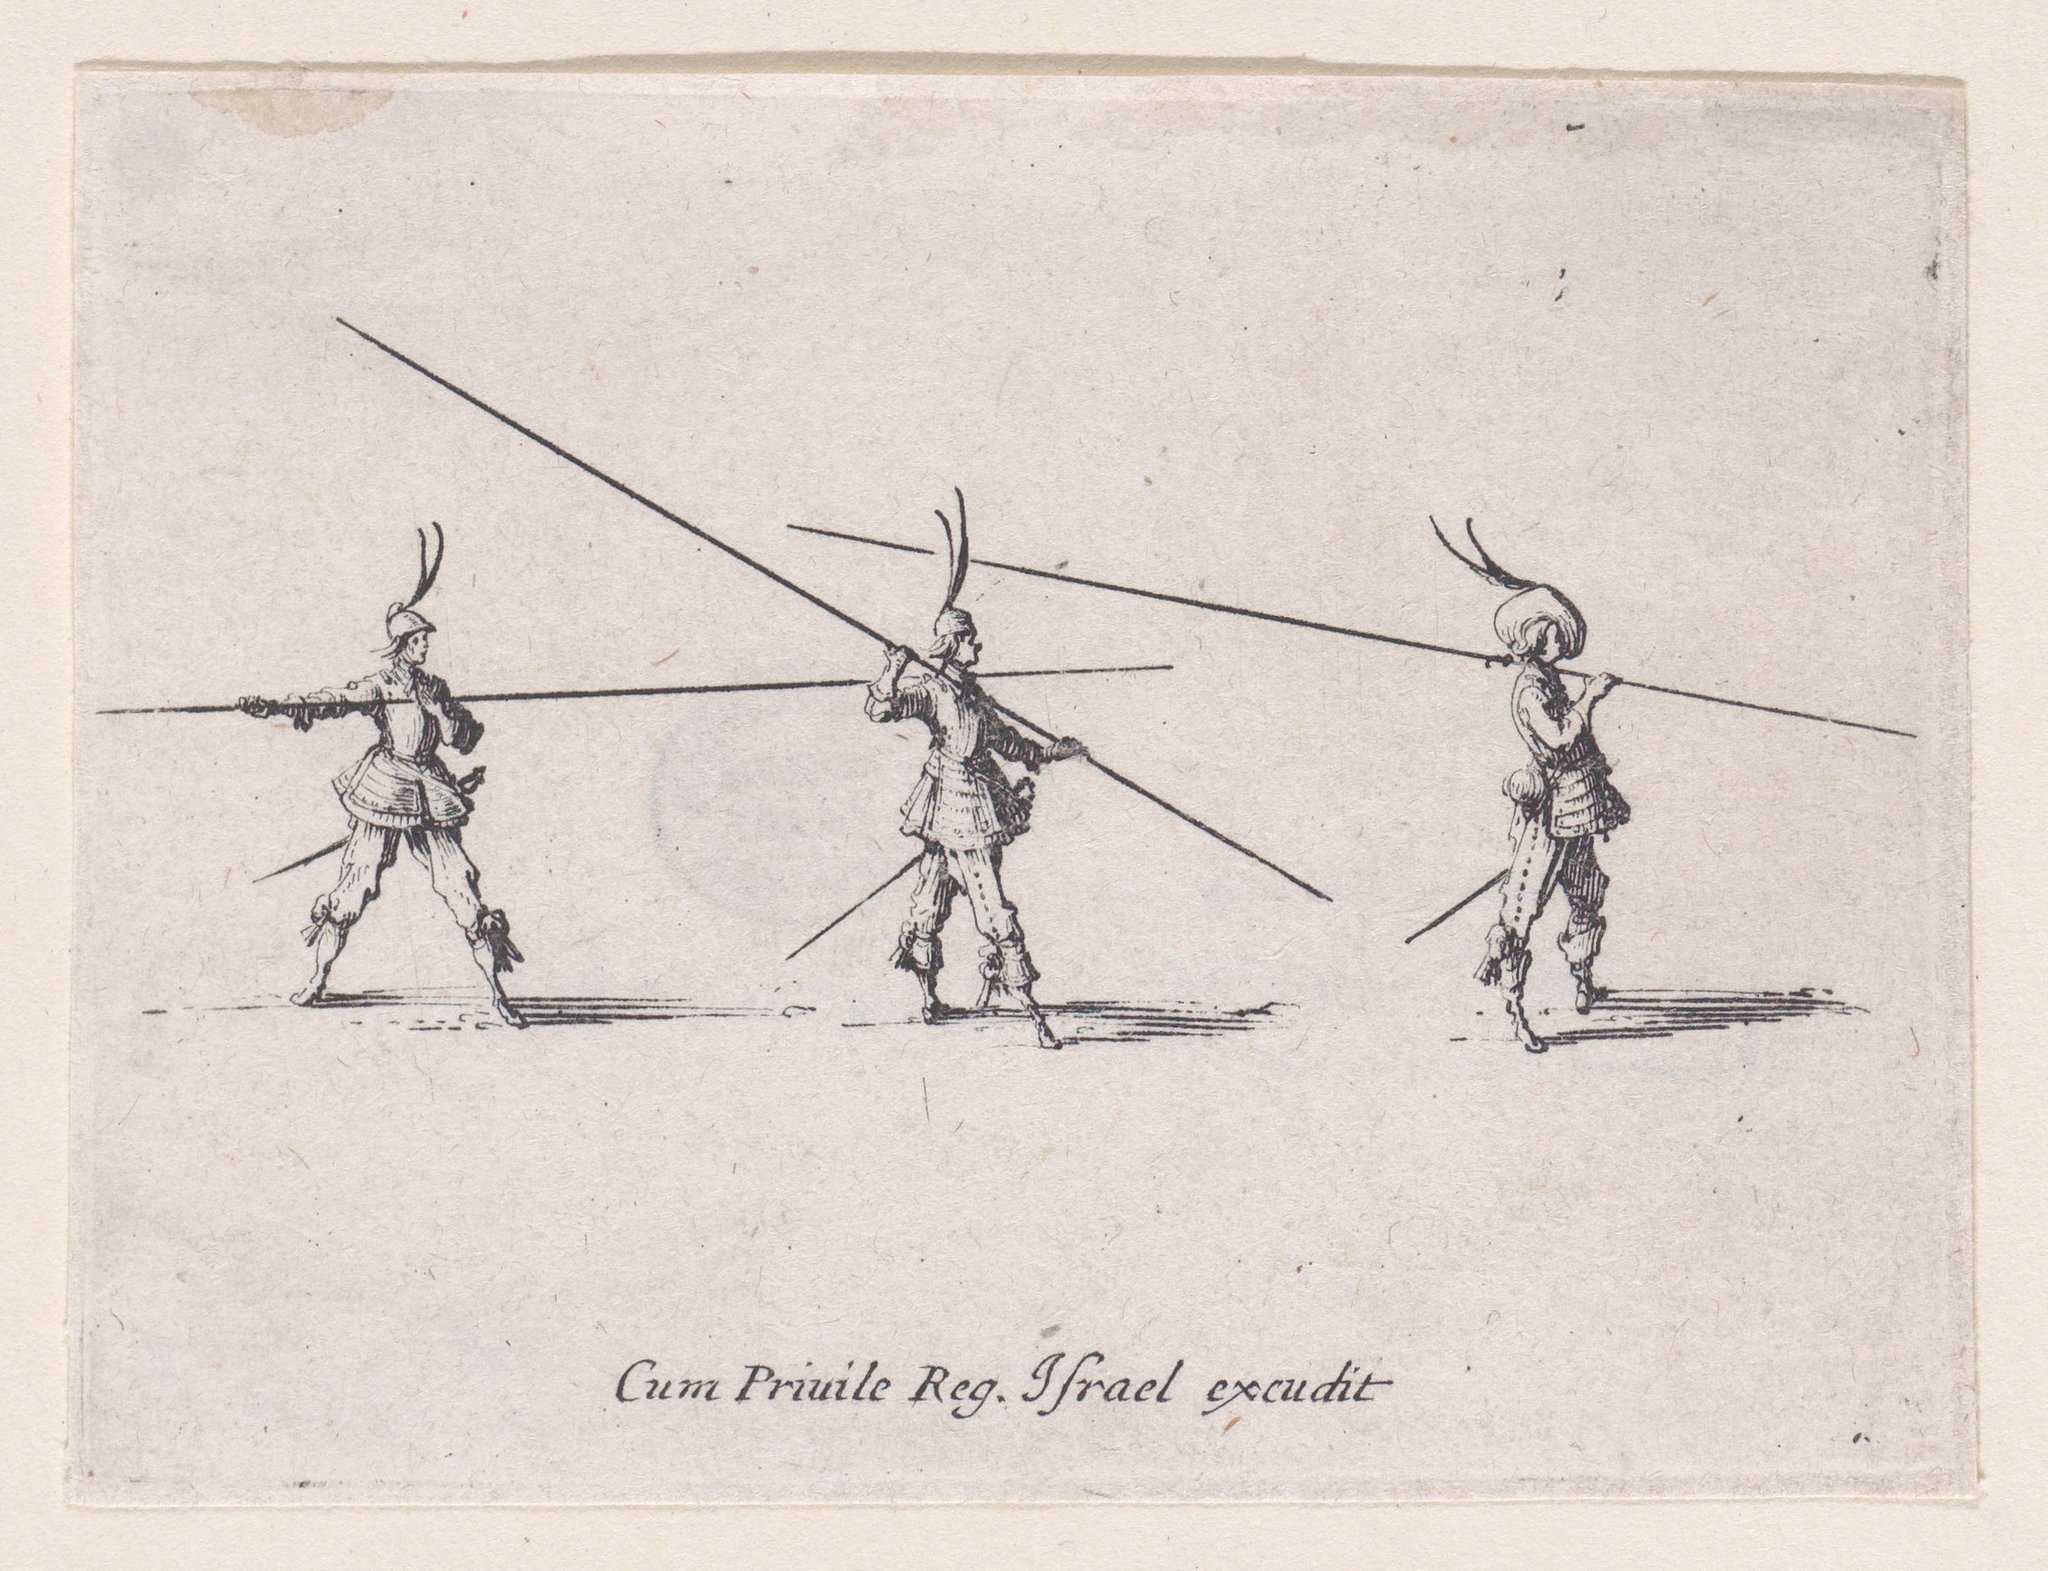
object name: print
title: L'Exercice de la Lance Horizontal (Drill with the Horizontal Lance), from "Les Exercices Militaires" (The Military Exercises)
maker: jacques callot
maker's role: artist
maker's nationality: french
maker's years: 1592-1635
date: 1635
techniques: etching